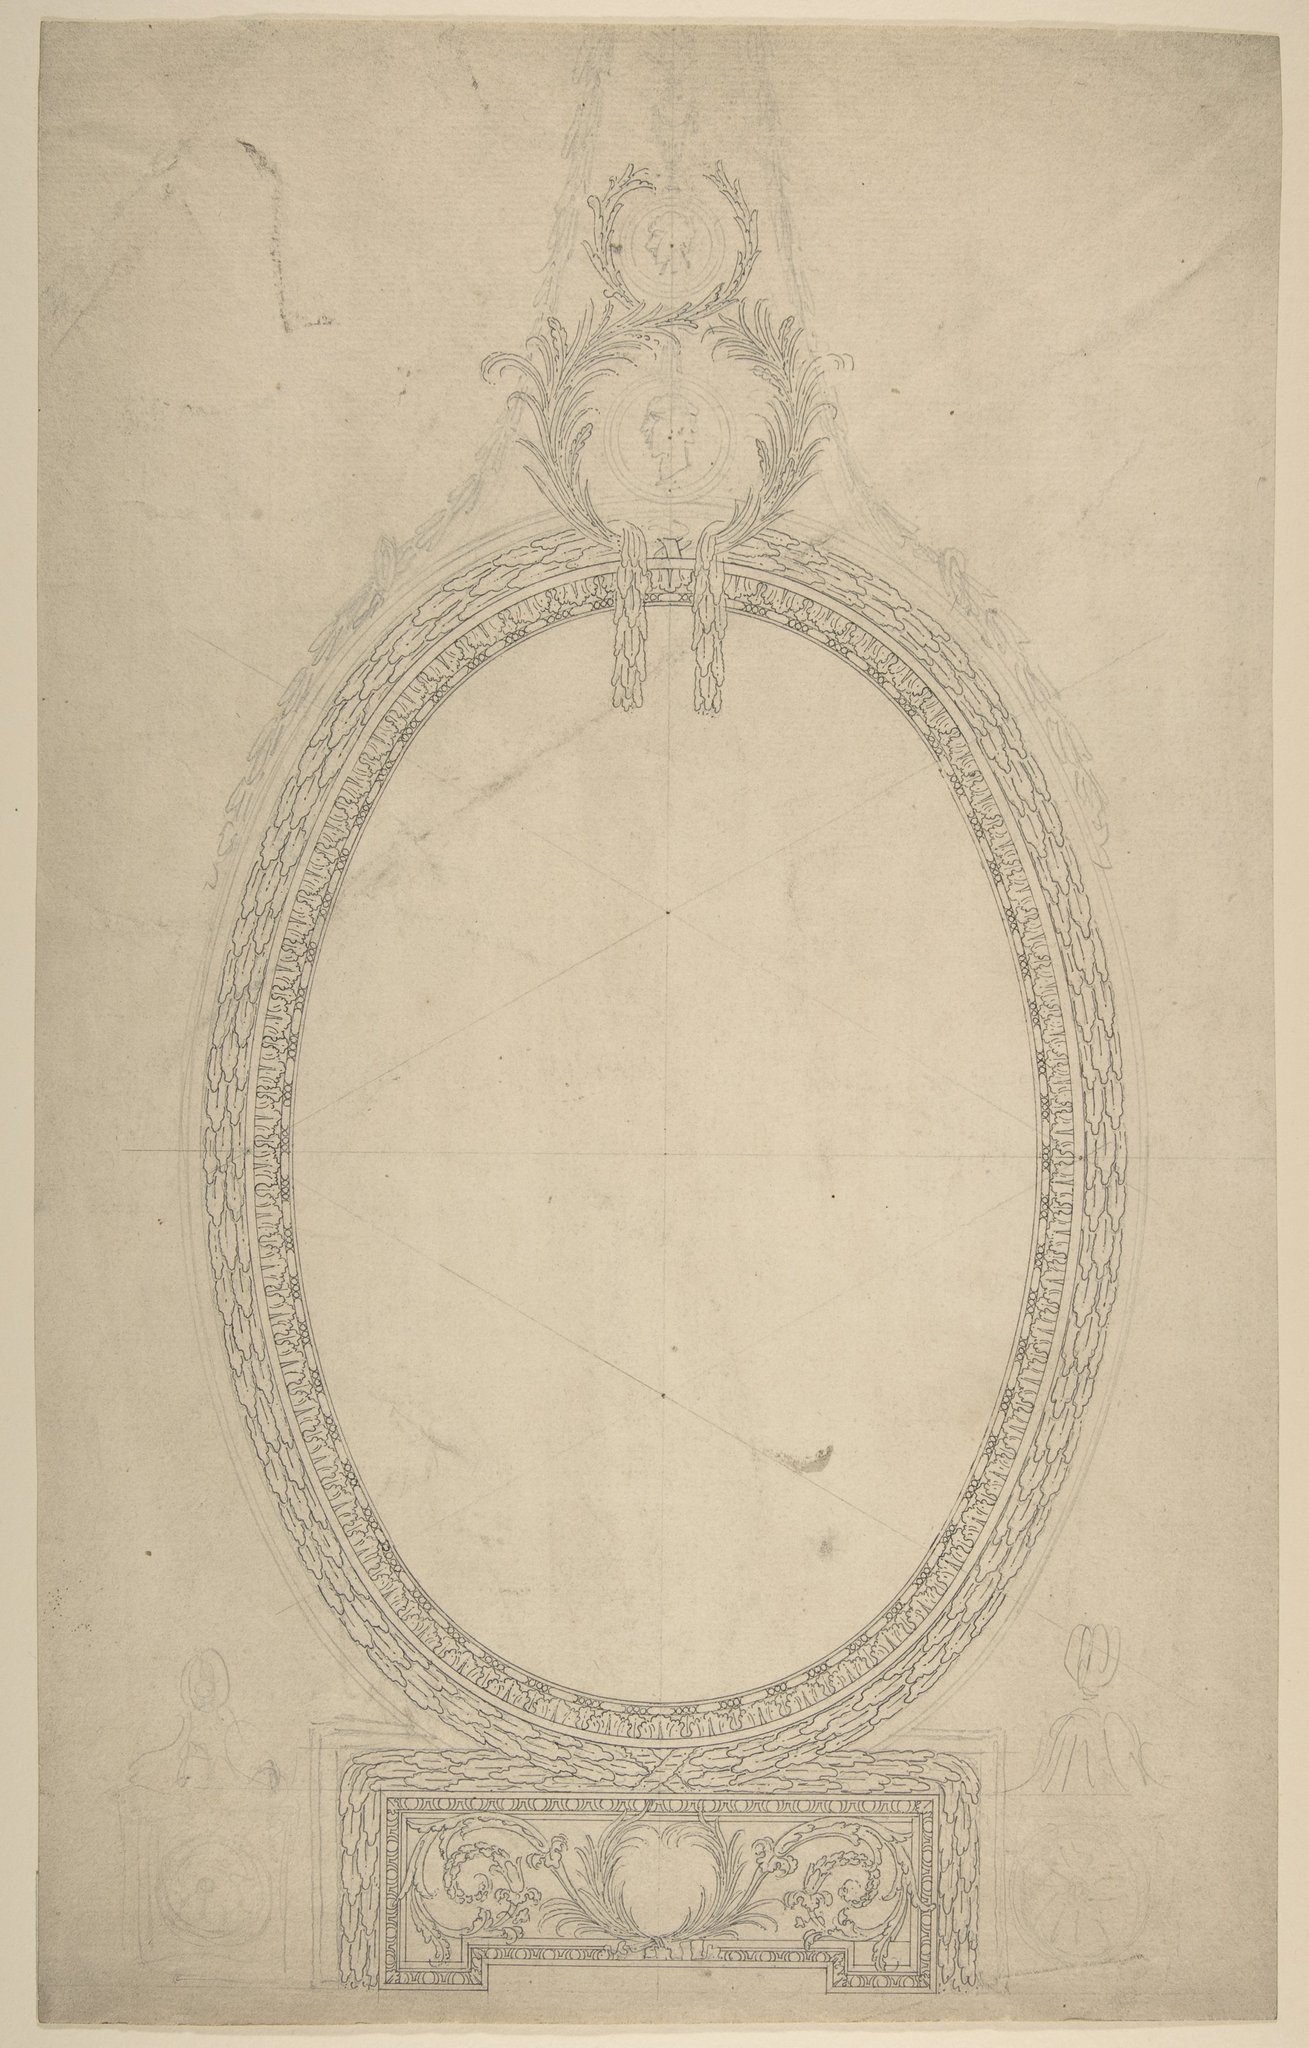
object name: drawing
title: Design for a Girandole Mirror, an Oval Resting on an Oblong Base, Terminated by Two Superimposed Circular Frond-motifs, Topped with a Lion's Head from Which Hang Floral Swags and Pendants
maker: sir william chambers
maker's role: artist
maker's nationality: british, born sweden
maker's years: 1723-1796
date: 1775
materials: watercolor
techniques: pen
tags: mirrors